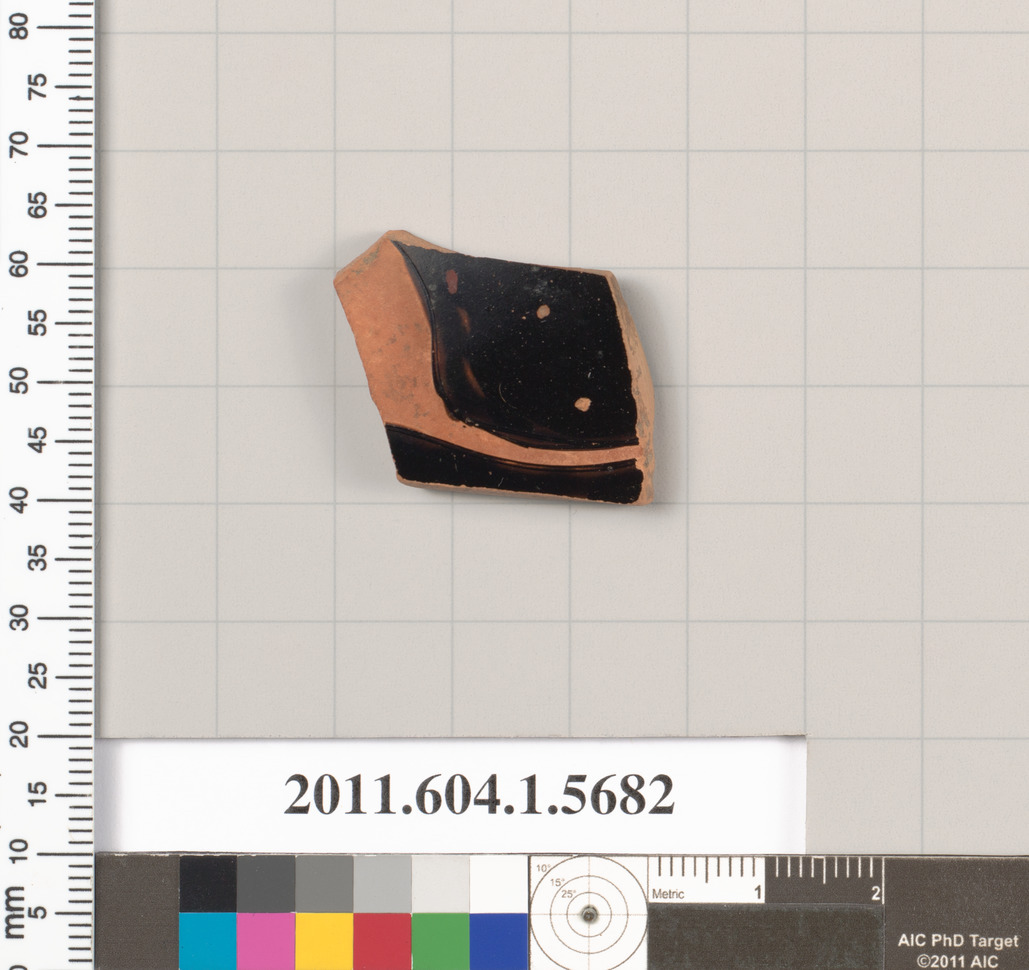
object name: kylix fragment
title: Terracotta fragment of a kylix (drinking cup)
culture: greek, attic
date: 500-480 BCE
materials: terracotta